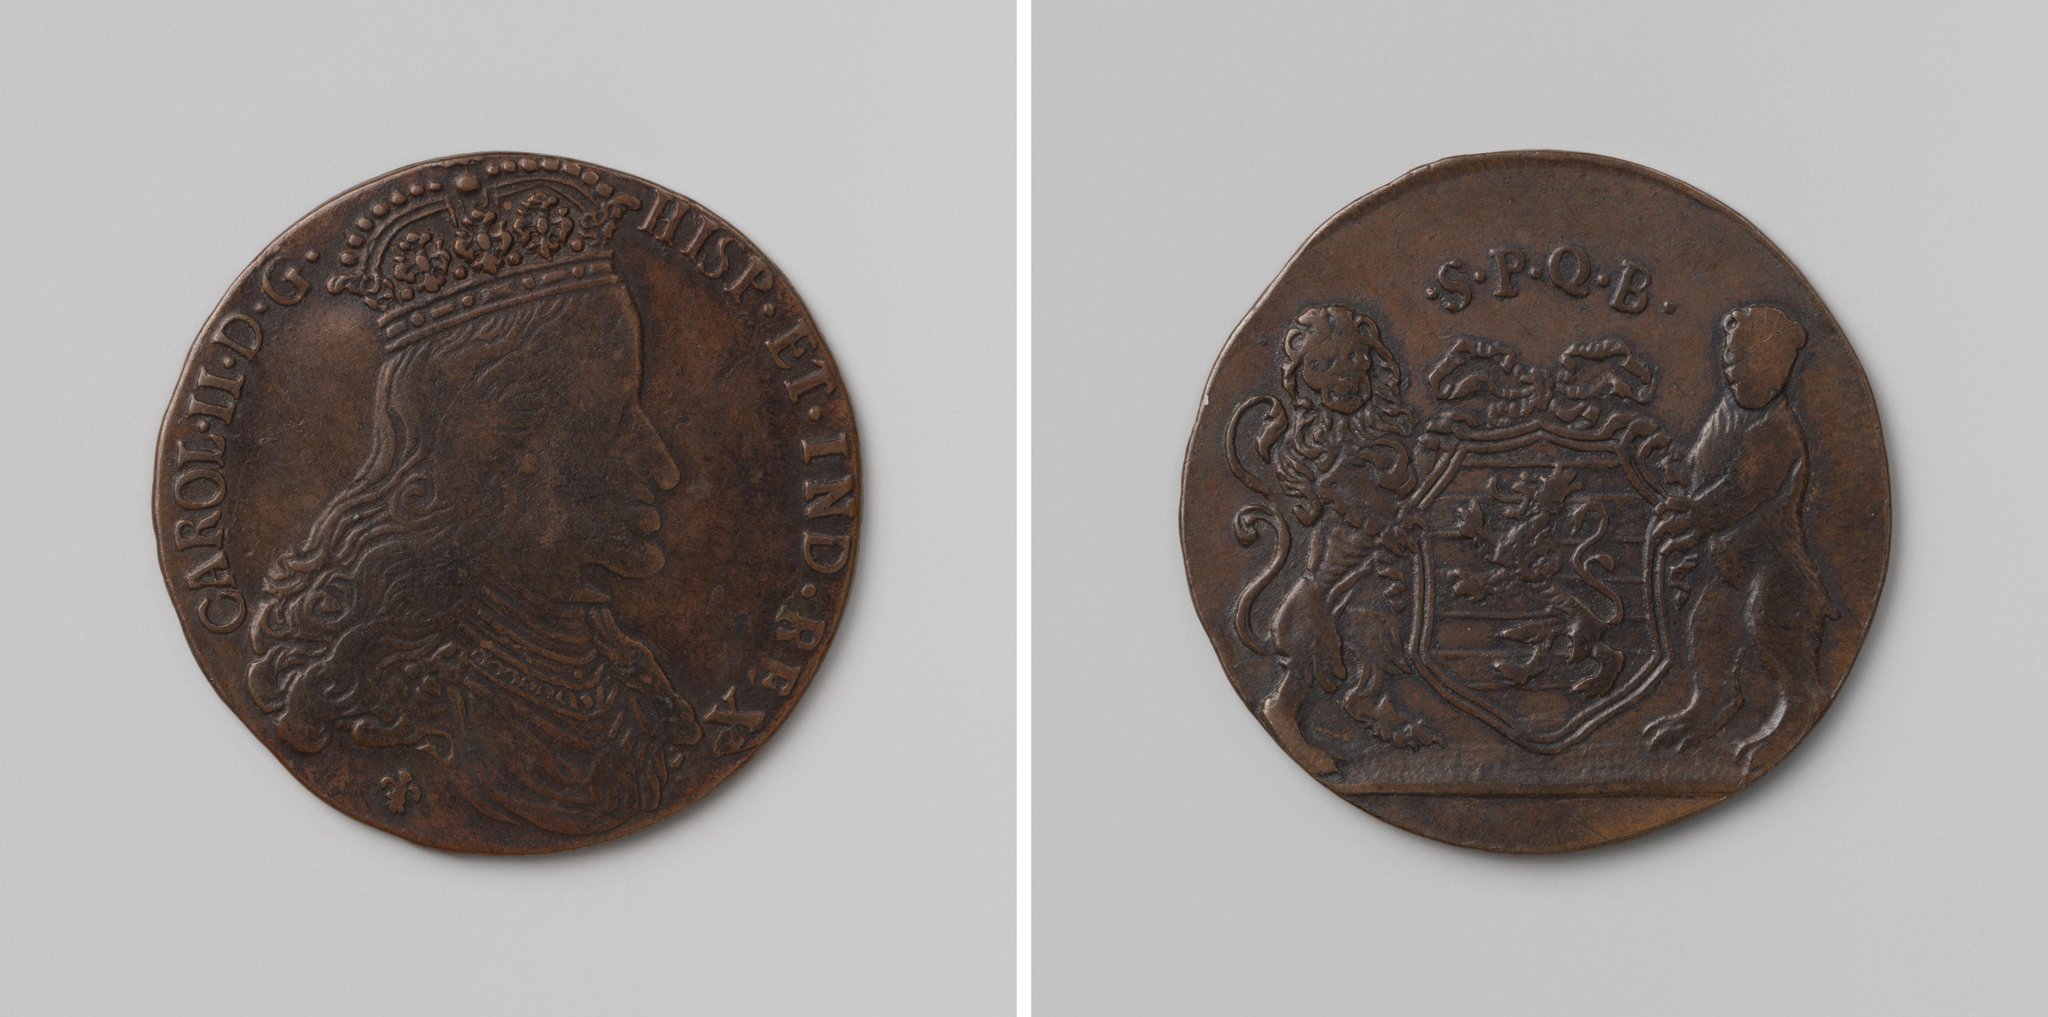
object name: jeton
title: Karel II, koning van Spanje, rekenpenning geslagen op last van de stad Brugge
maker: philippe roëttiers (ii)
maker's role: medailleur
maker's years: 1640-1718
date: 1696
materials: copper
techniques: striking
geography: antwerp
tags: karel ii (koning van spanje), bruges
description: Koperen penning. Voorzijde: borststuk man binnen omschrift. Keerzijde: wapenschild, geflankeerd door leeuw en beer